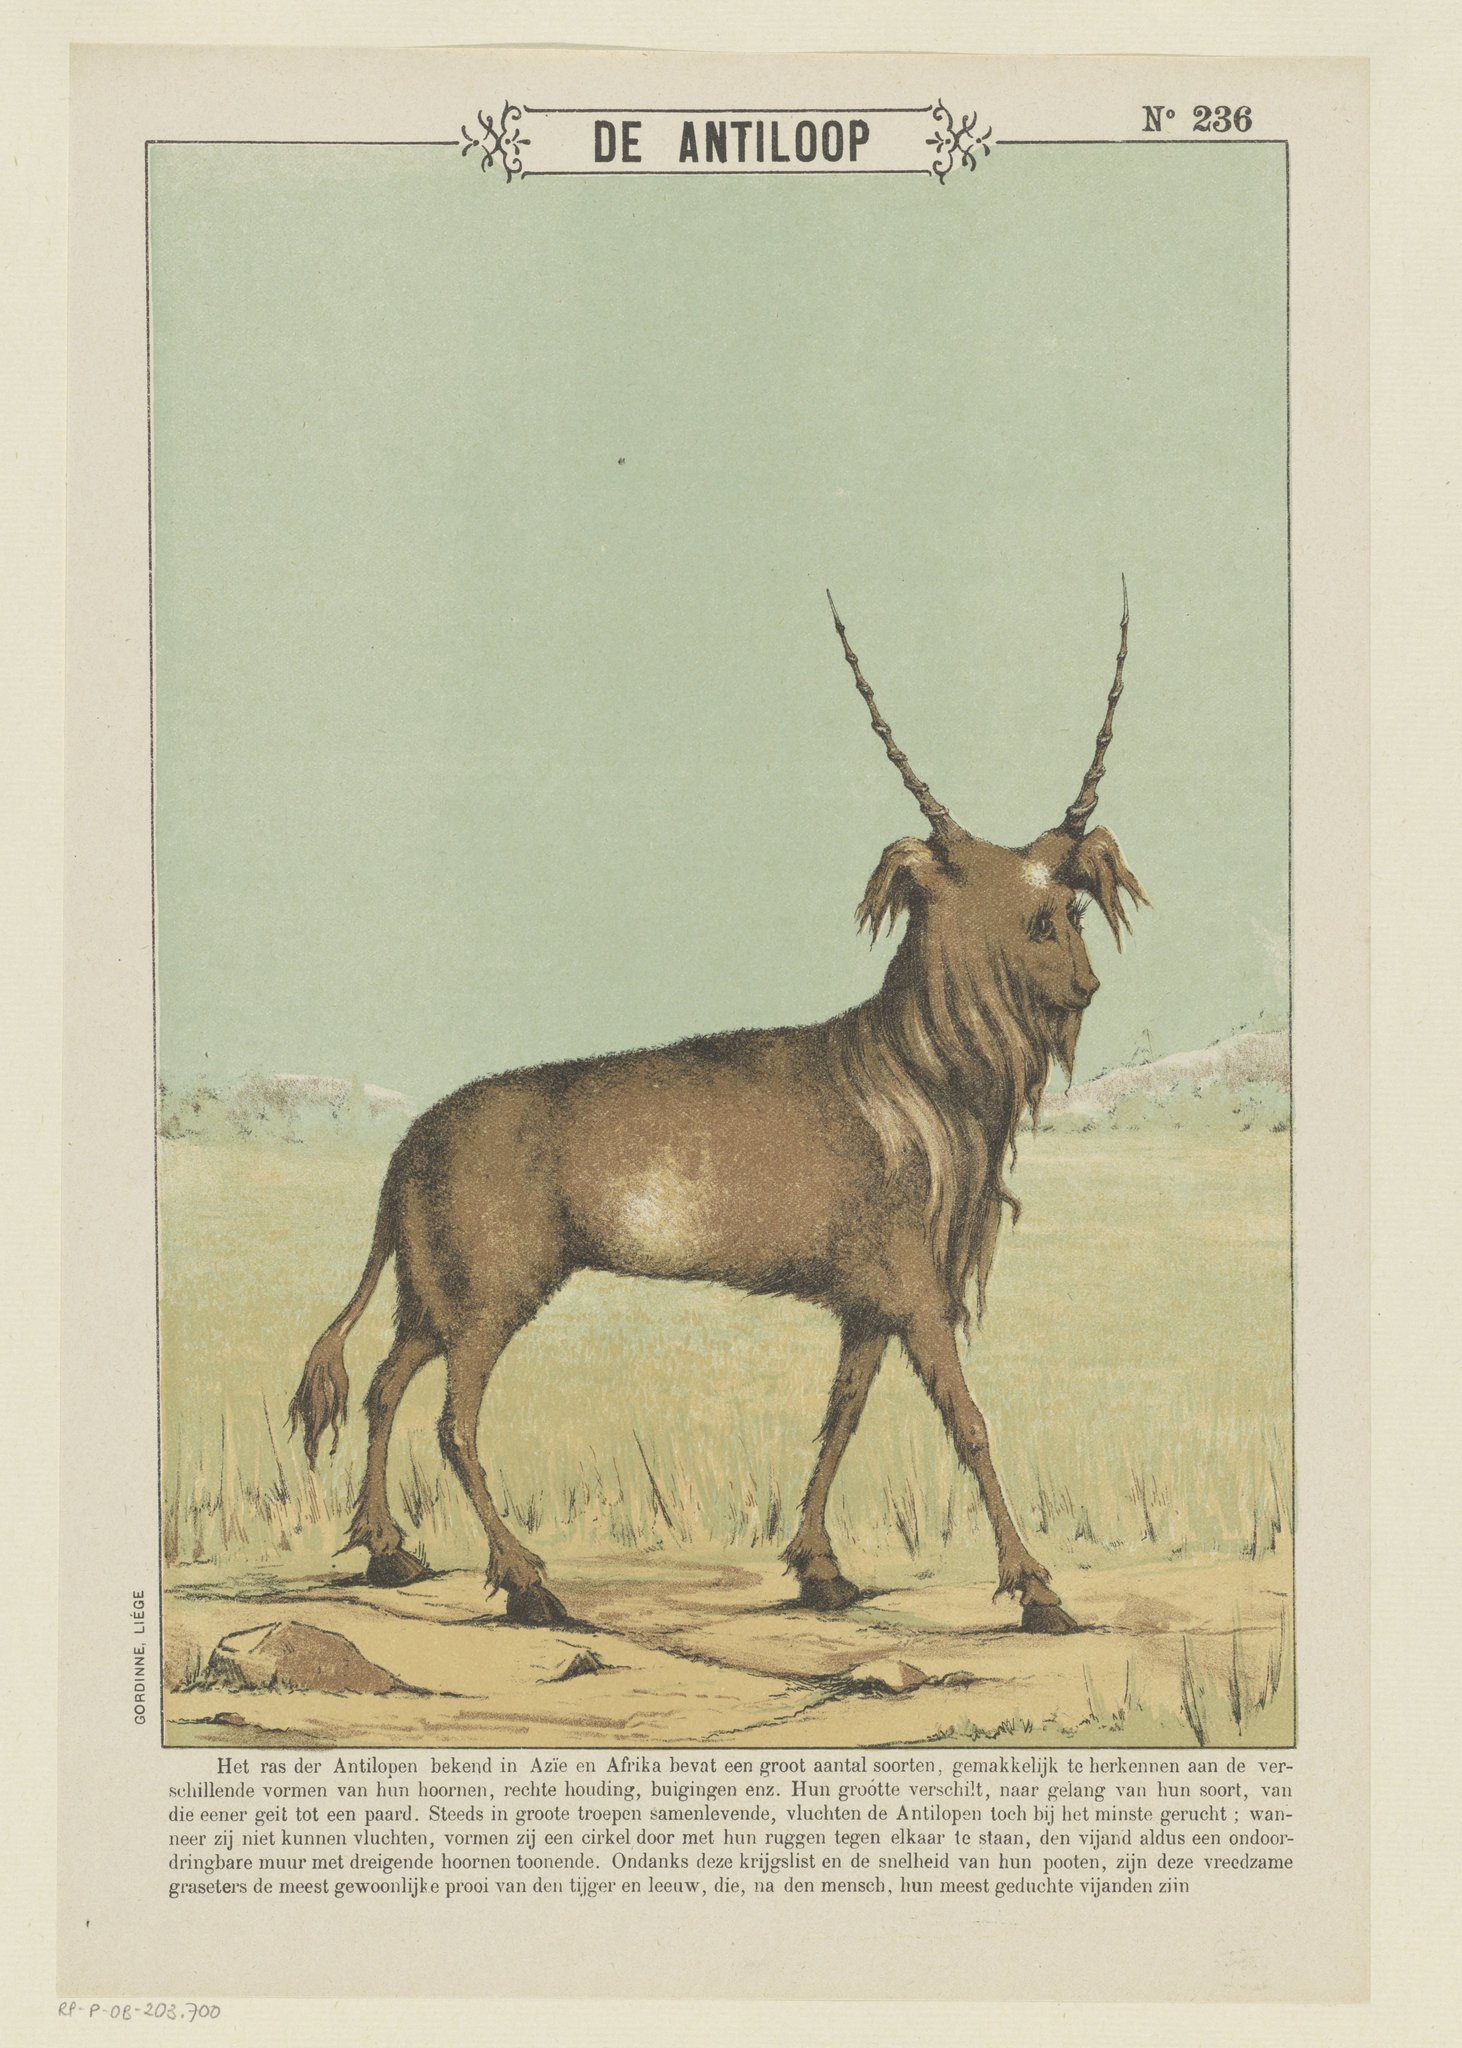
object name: popular print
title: De antiloop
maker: Anonymous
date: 1894-1959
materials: paper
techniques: lithograph, letterpress printing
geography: liège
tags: hoofed animals: antelope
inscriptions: collector's mark: Lugt 2760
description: Blad met een grote voorstelling van een antilope. In de ondermarge een onderschrift. Genummerd rechtsboven: No 236.